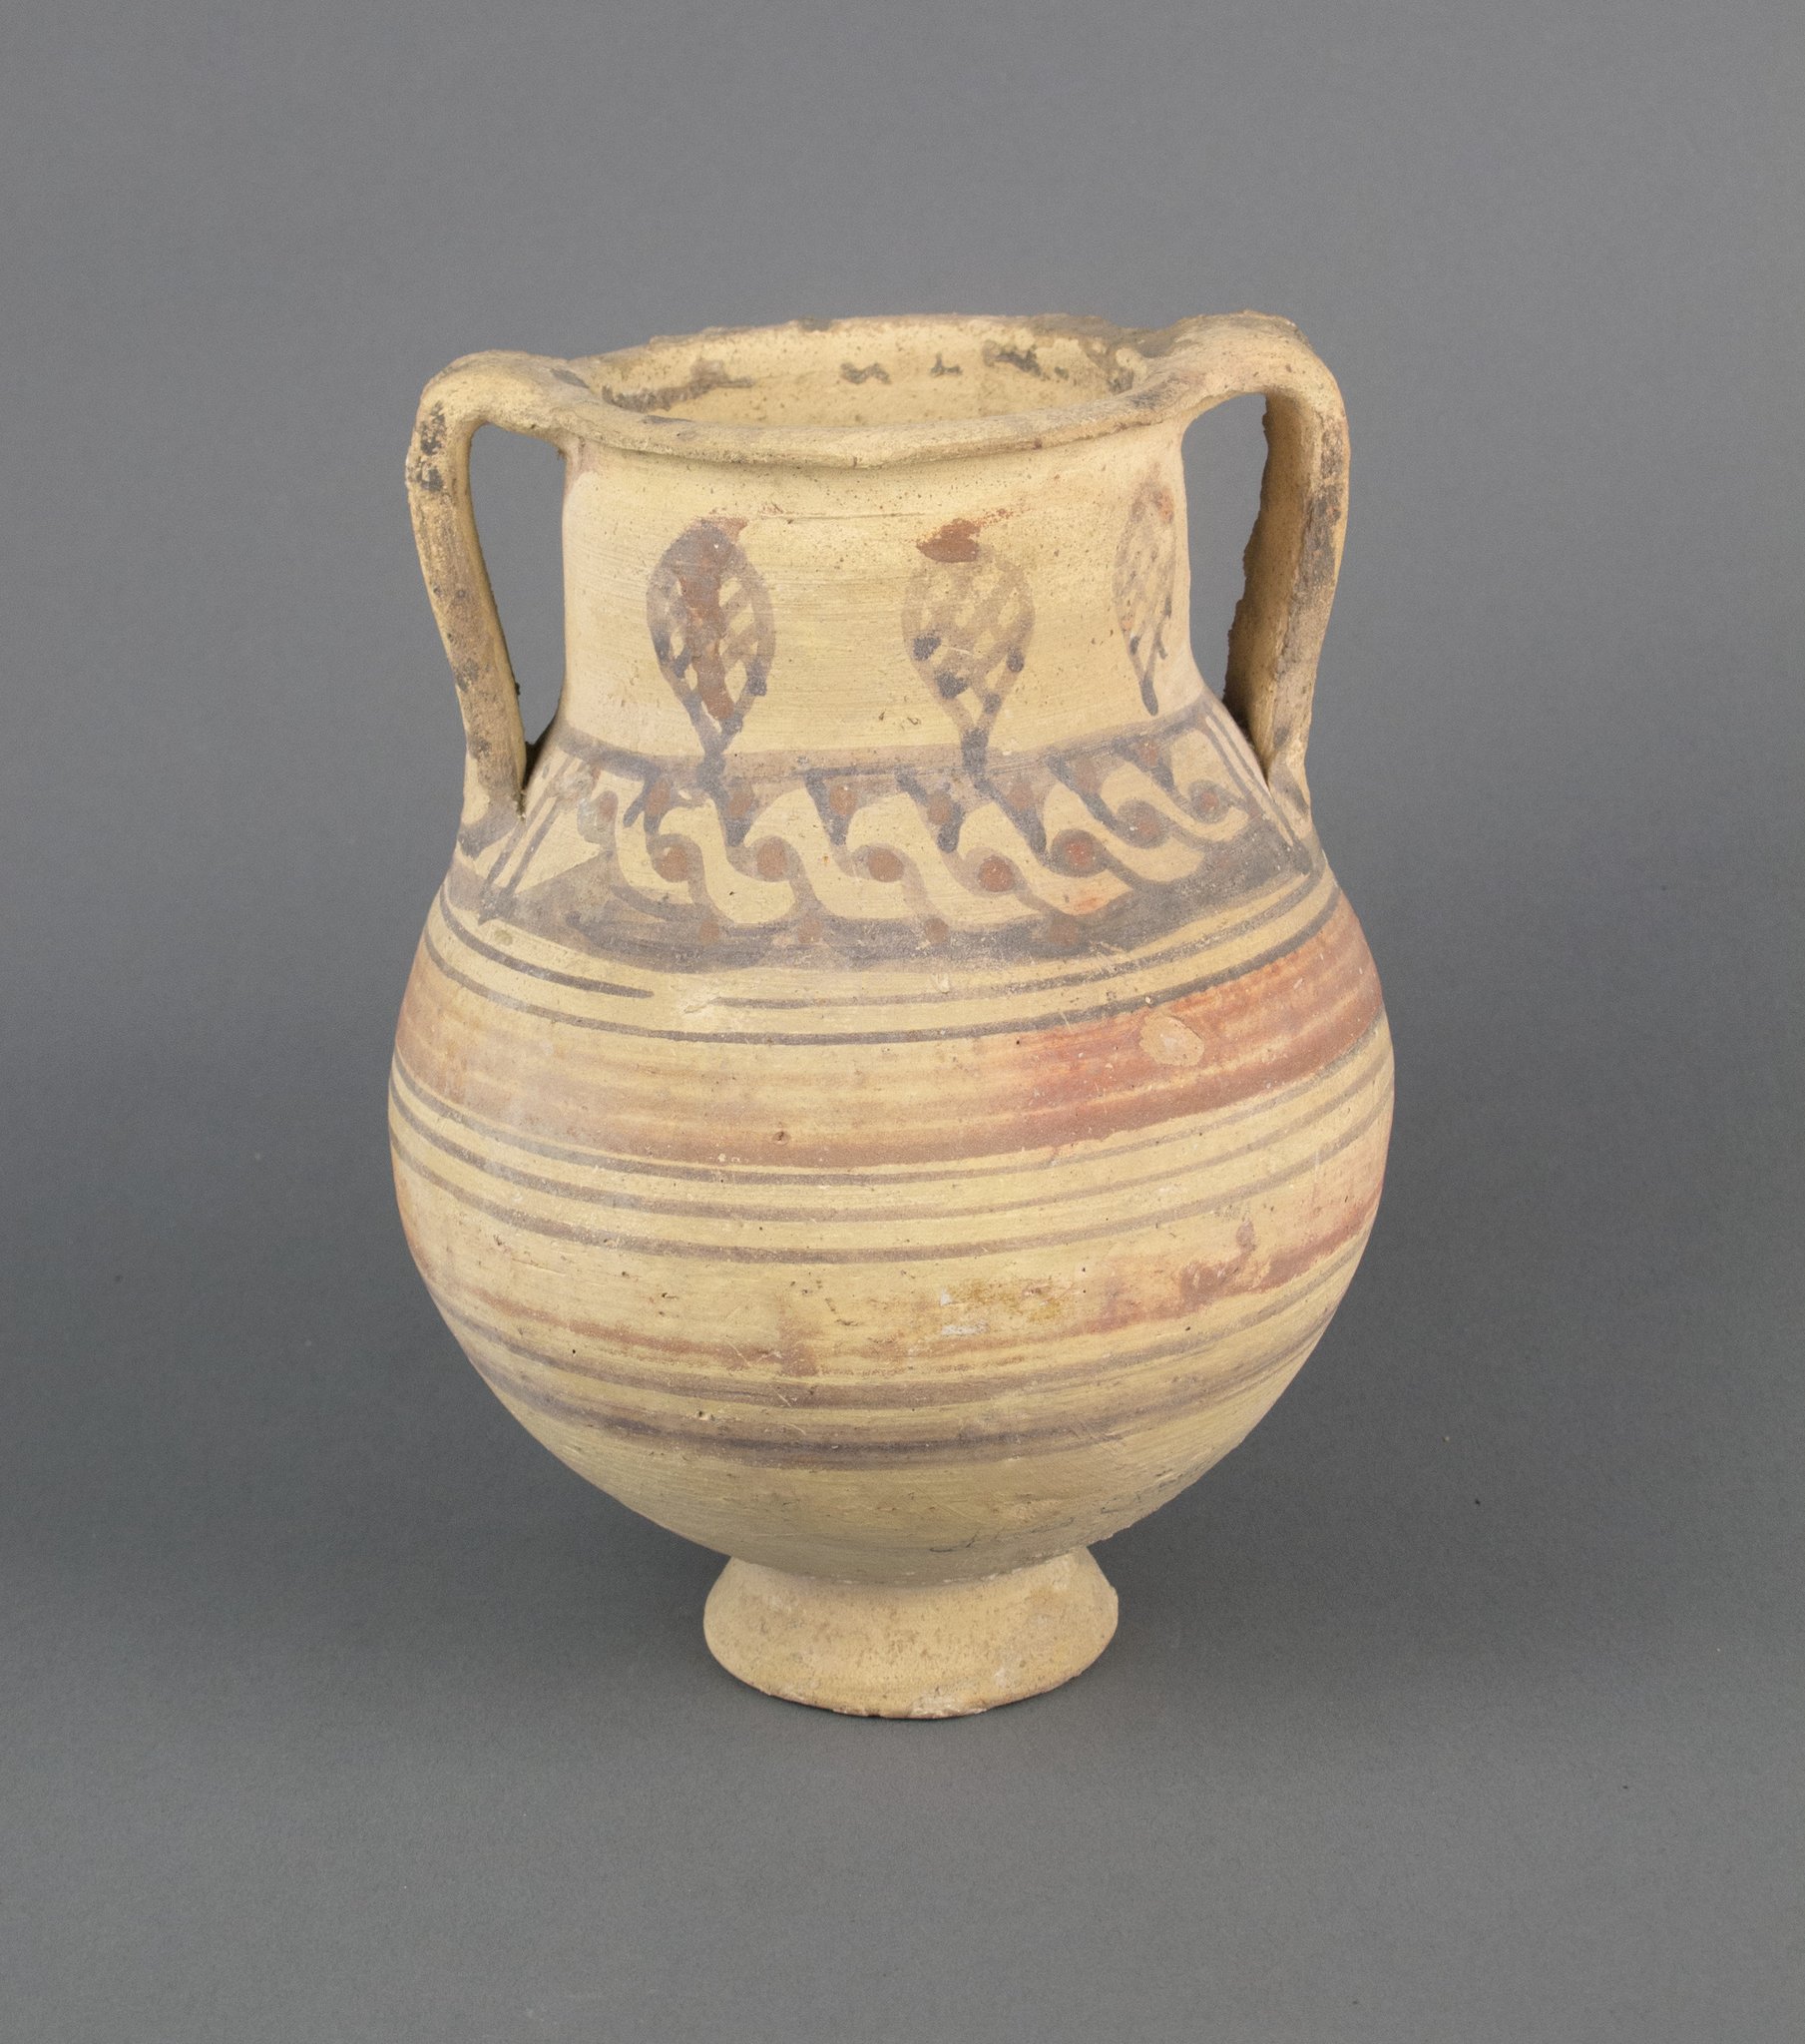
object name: amphoriskos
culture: cypriot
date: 600-480 BCE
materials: terracotta